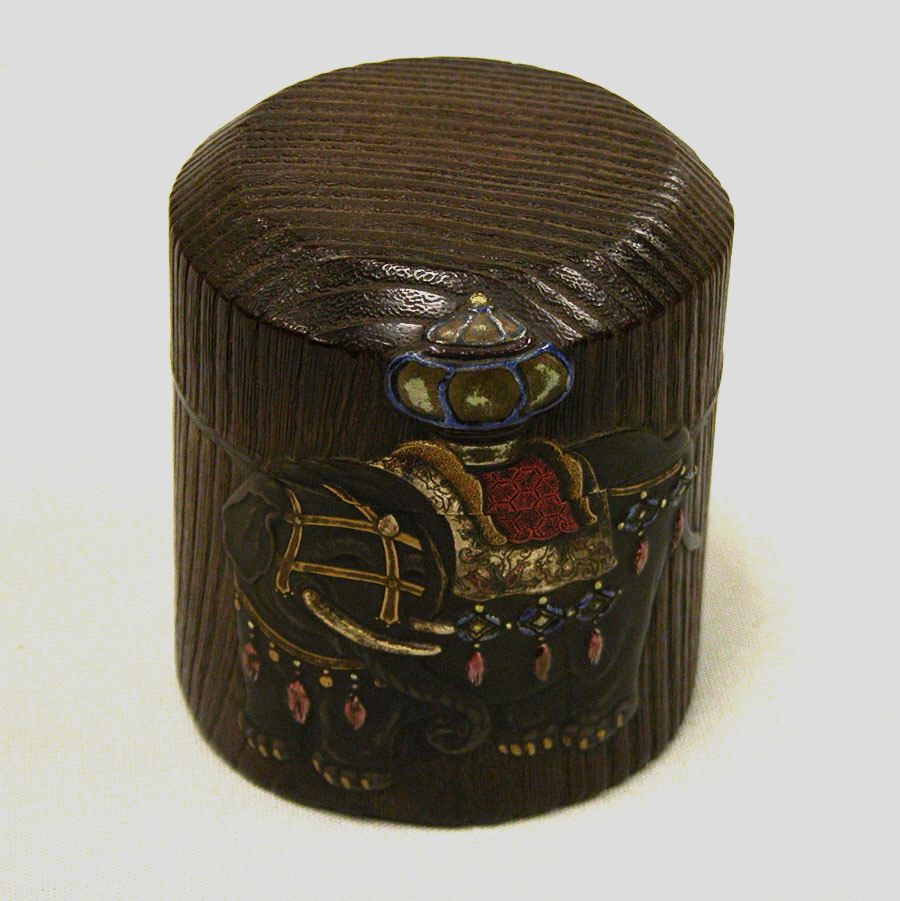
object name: tea caddy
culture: japanese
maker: ogawa haritsu (ritsuō)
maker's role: artist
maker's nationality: japanese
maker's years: 1663-1747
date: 1663-1747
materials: lacquer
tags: elephants